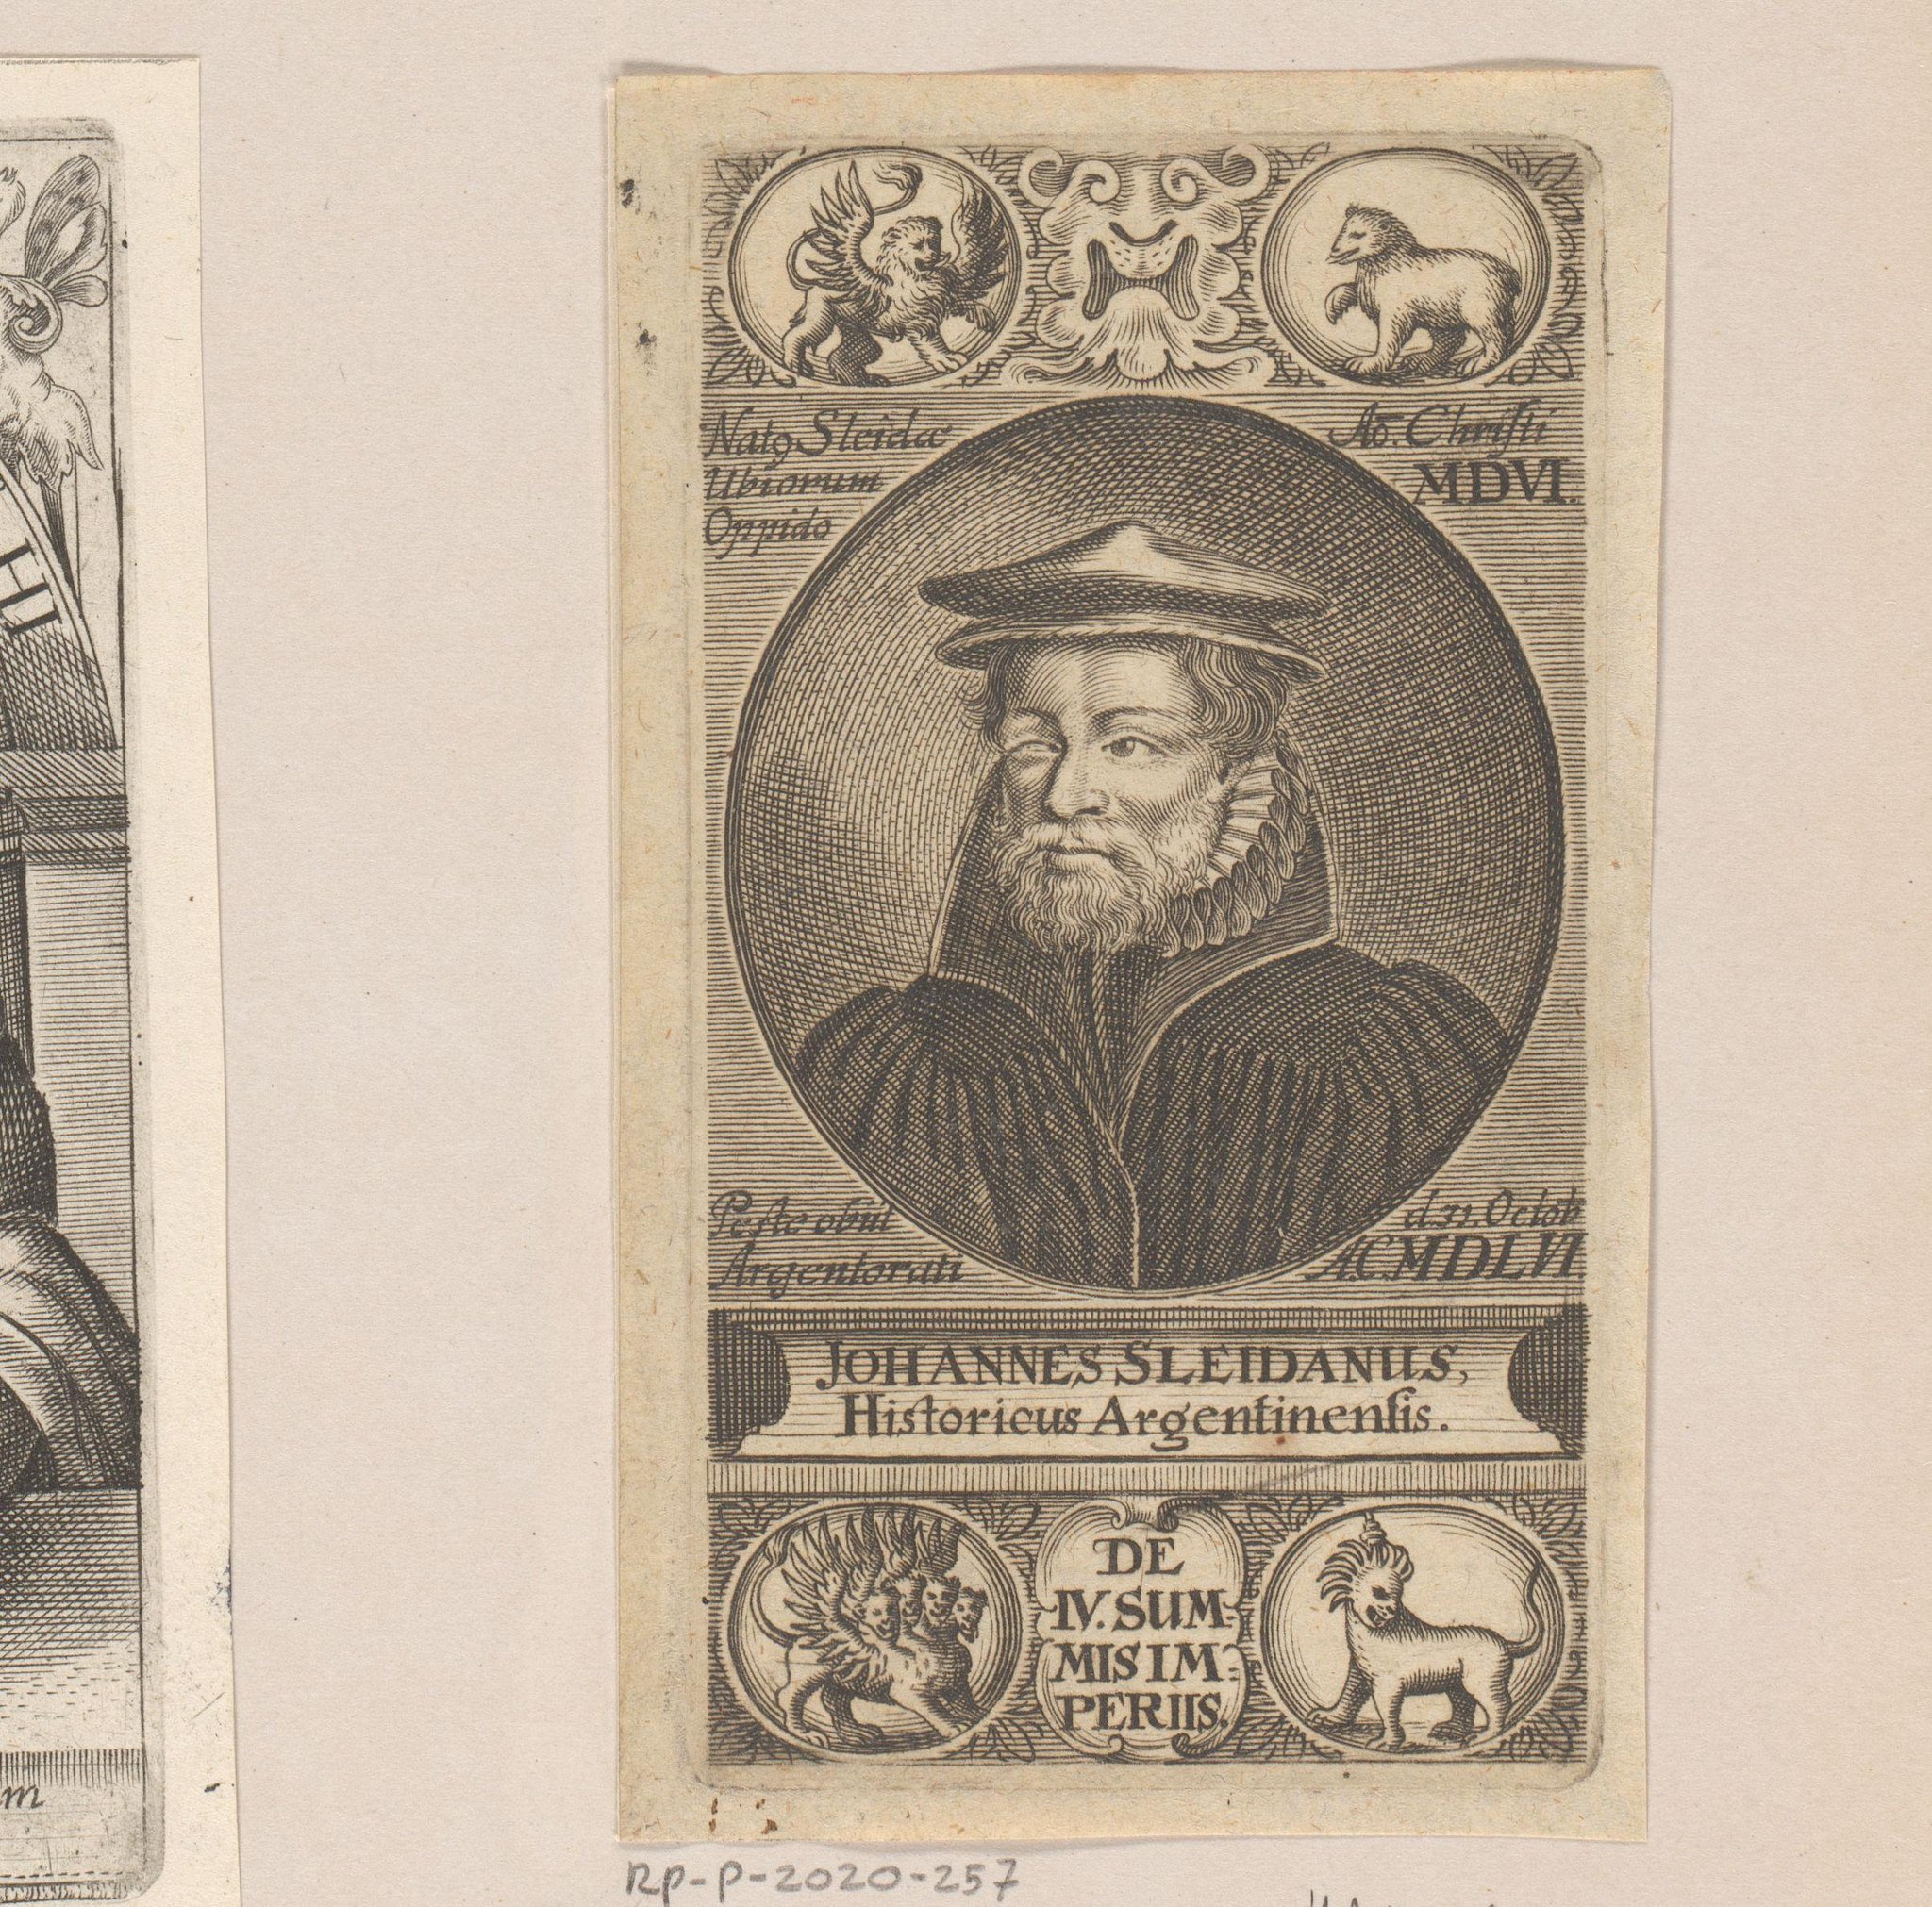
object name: print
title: Johannes Sleidanus, historicus Argentinensis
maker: Anonymous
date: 1600-1699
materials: paper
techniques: engraving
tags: historical persons, diplomacy, diplomat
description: In een medaillon. Boven het portret en onder de titel vier medaillons met mythologische dieren.